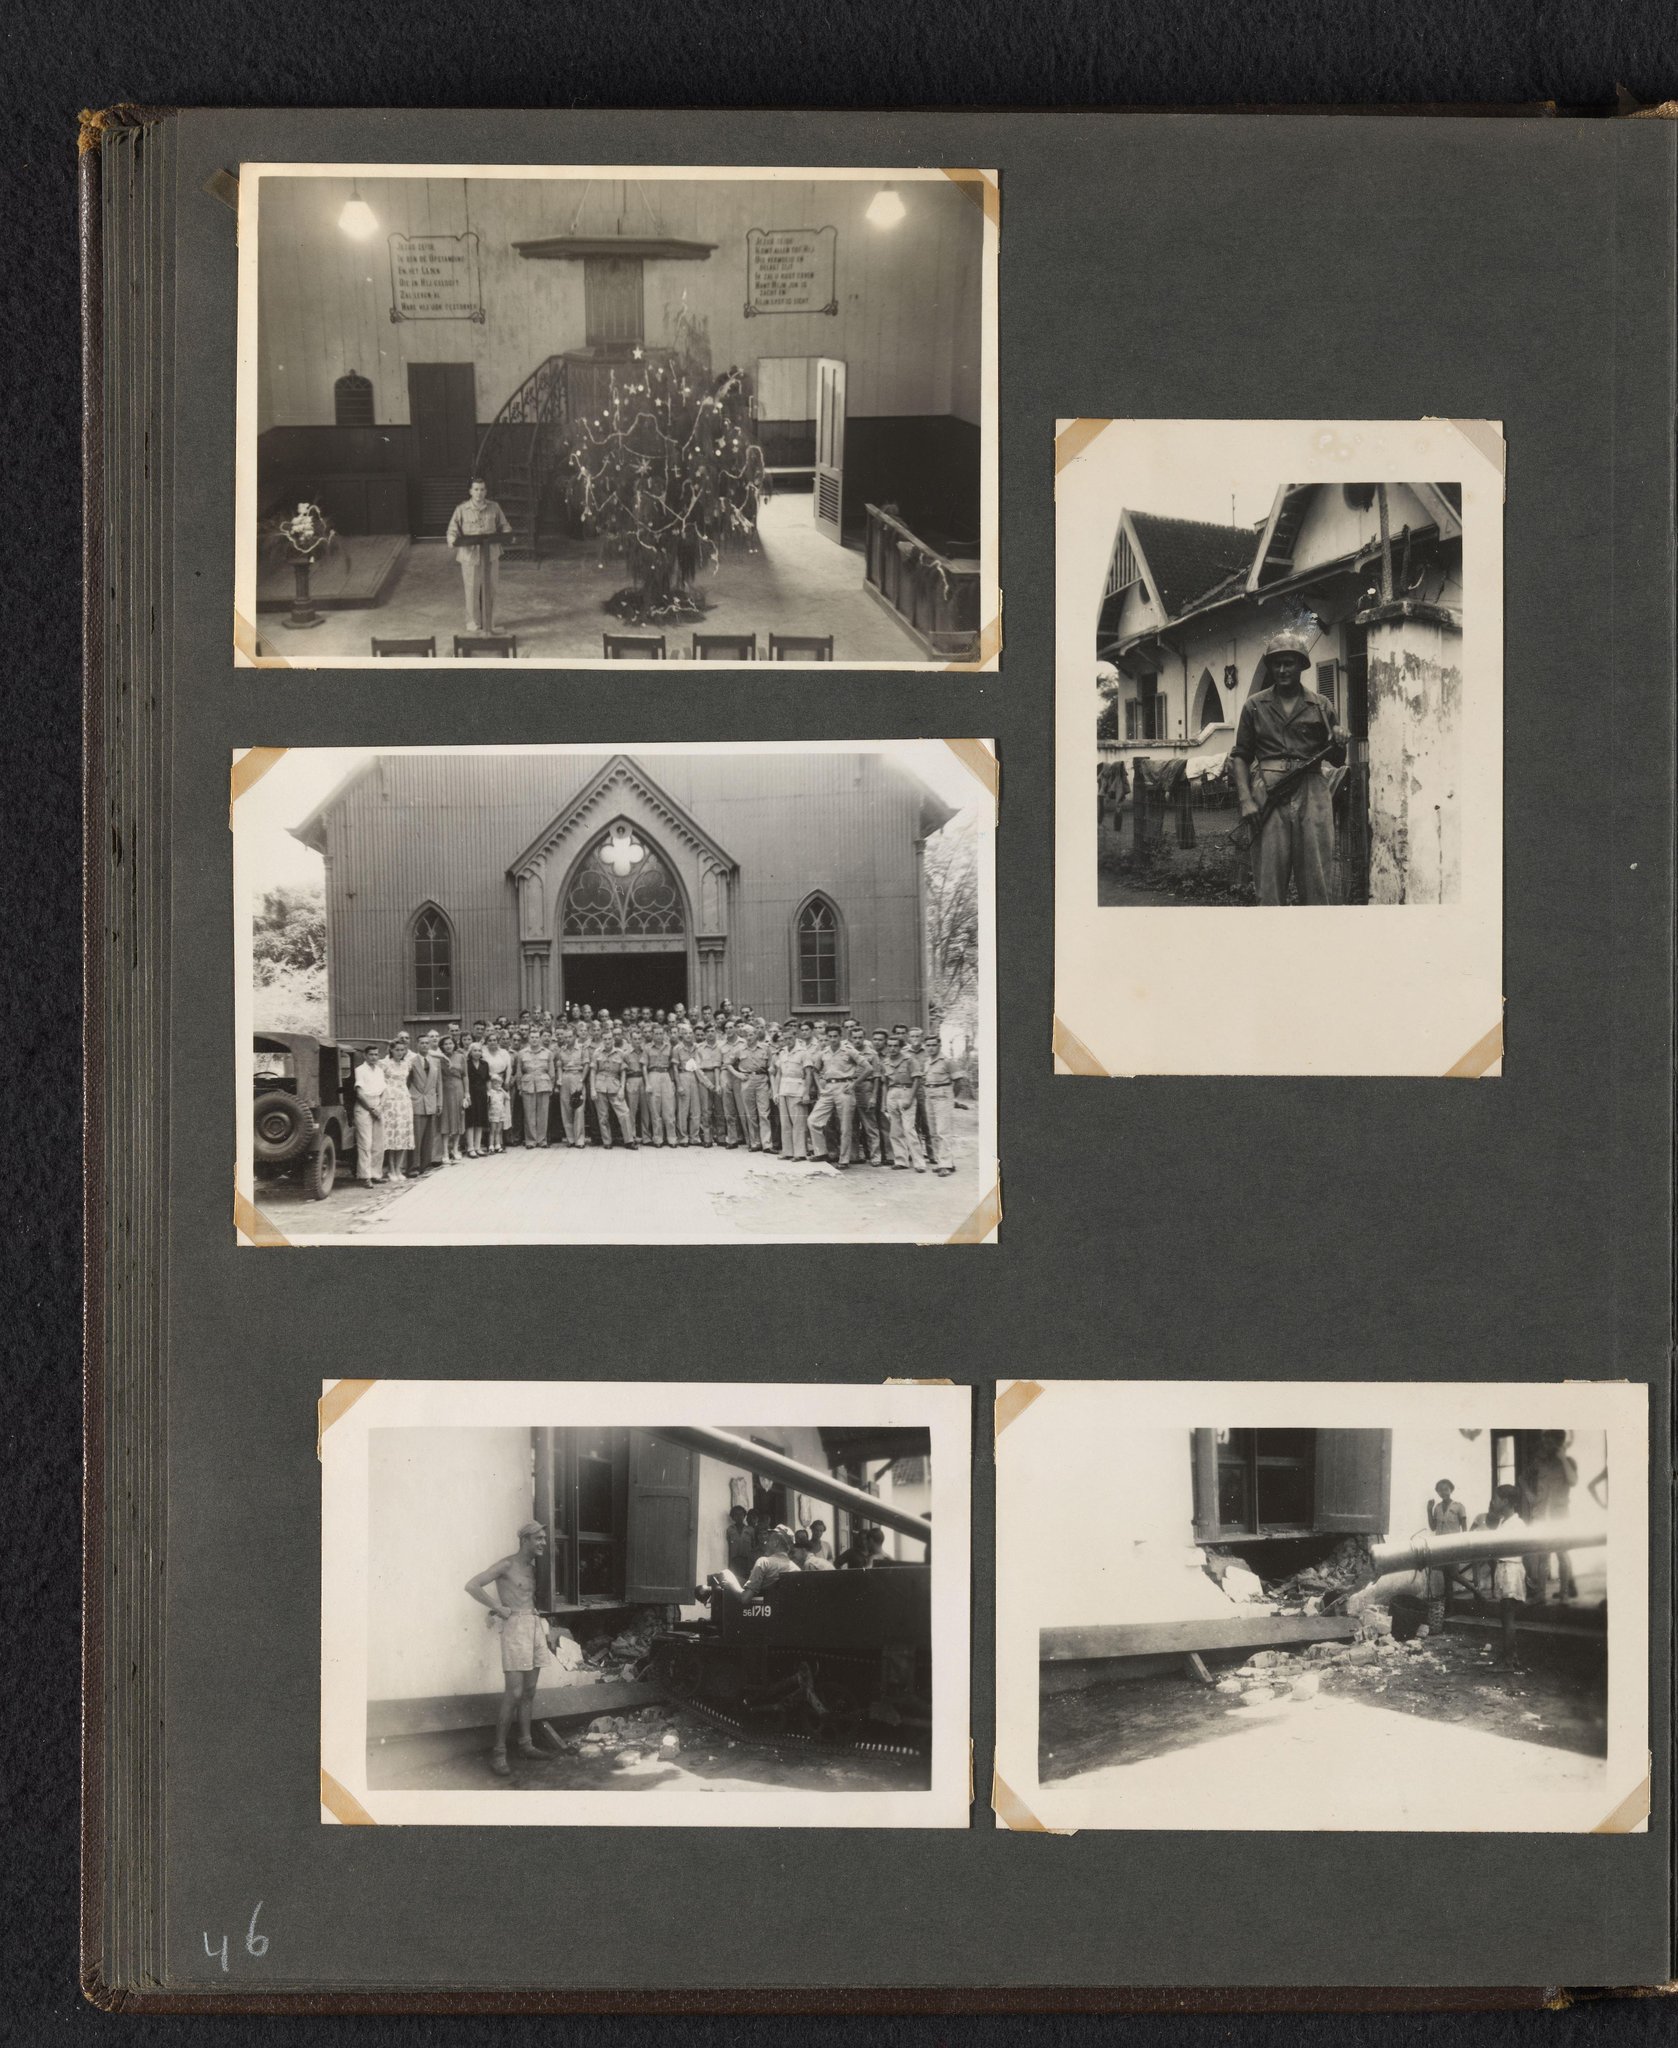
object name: photograph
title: Kerkdienst en militaire acties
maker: Anonymous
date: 1912-1950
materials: cardboard, photographic support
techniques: gelatin silver print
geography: dutch east indies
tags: christmas (ecclesiastical feast), military service, modern forms of military vehicles, interior of church, dutch east indies, the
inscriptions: inscription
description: Albumblad met vijf foto's van een kerkdienst voor de Nederlandse militairen op kerstmis 1950 in Probolinggo, en van militaire acties in Djati (Jatiroto?). Onderdeel van het fotoalbum 'Mijn jaren in Indië' met foto's over de militaire acties in Nederlands-Indië.